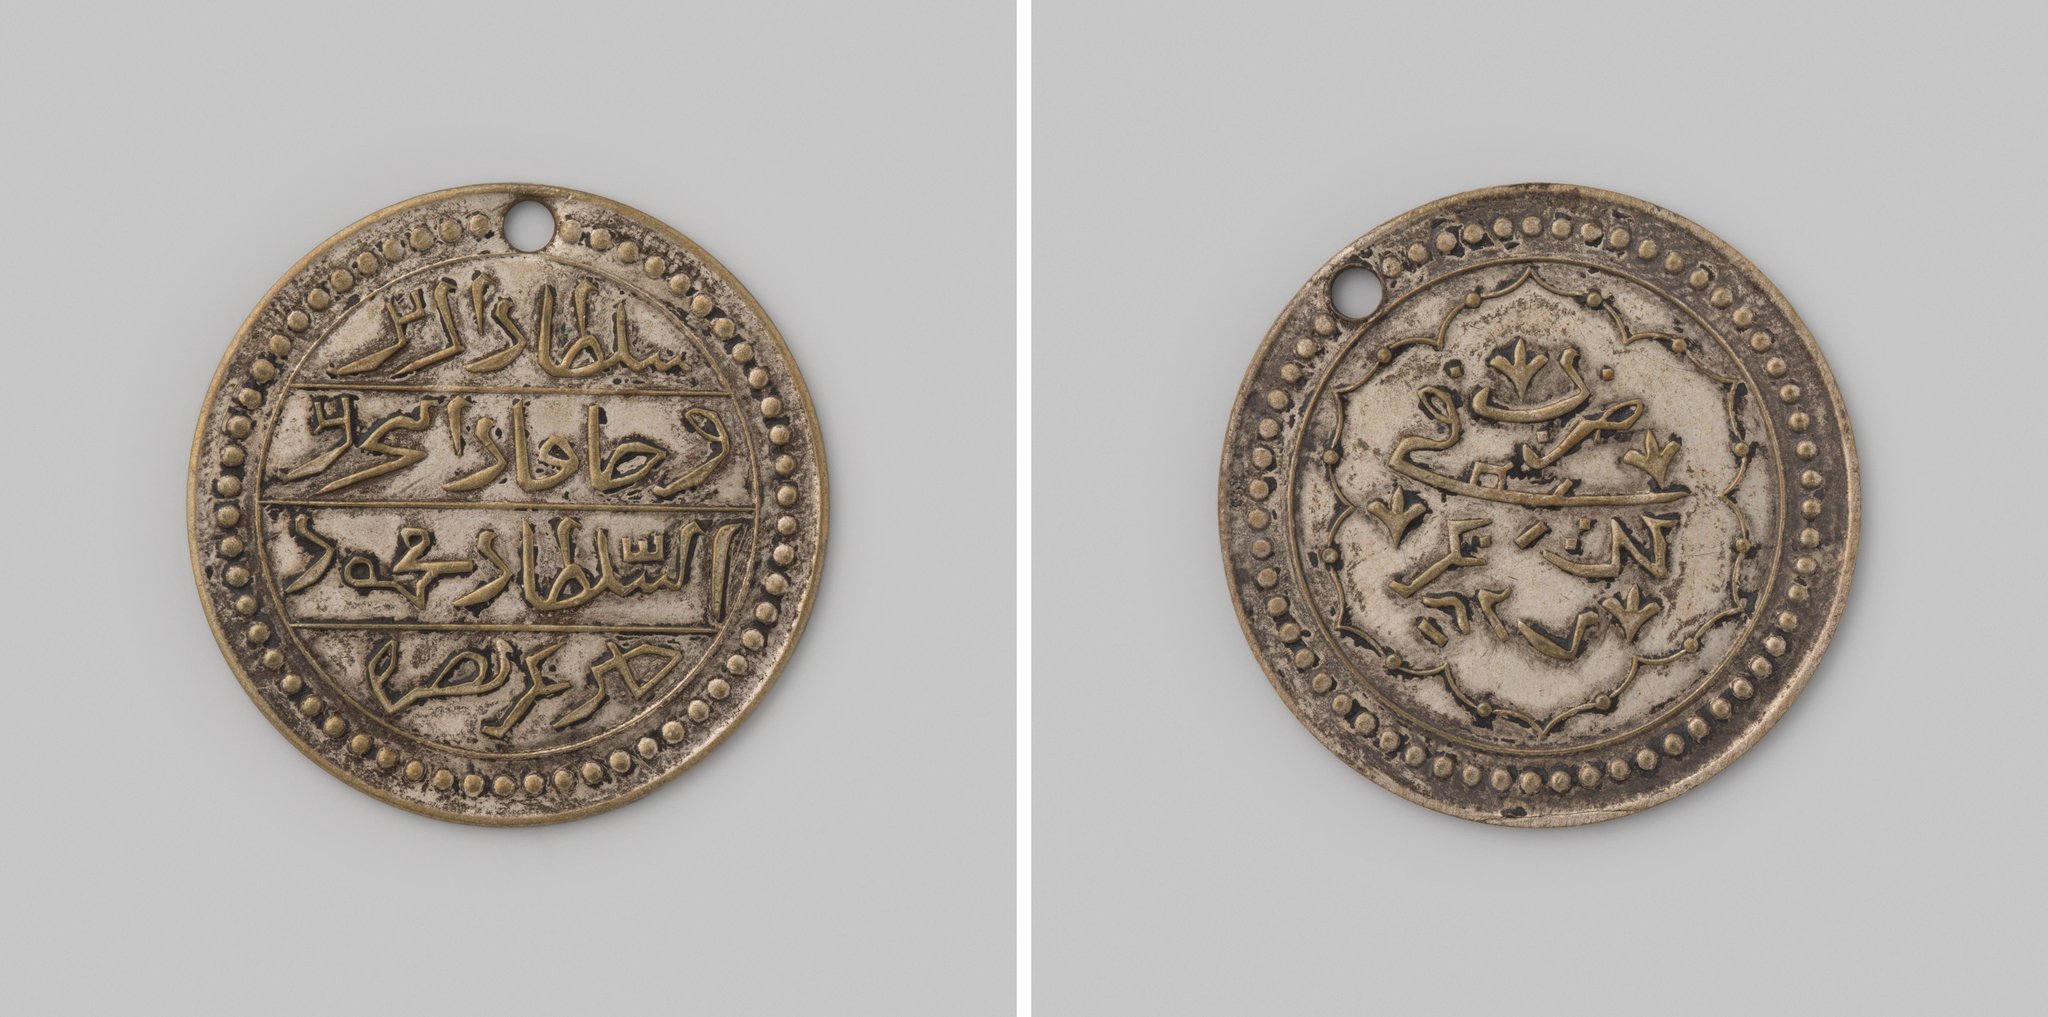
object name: history medal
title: Hanger in de vorm van een Tunesische munt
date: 1800-1875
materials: brass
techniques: striking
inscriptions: inscription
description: Verzilverd messing penning met doorboring, op de voorzijde vier regels arabisch schrift, op de keerzijde arabisch schrift. Imitatie van een Ottomaanse munt uit Tunis, jaartal verbasterd.